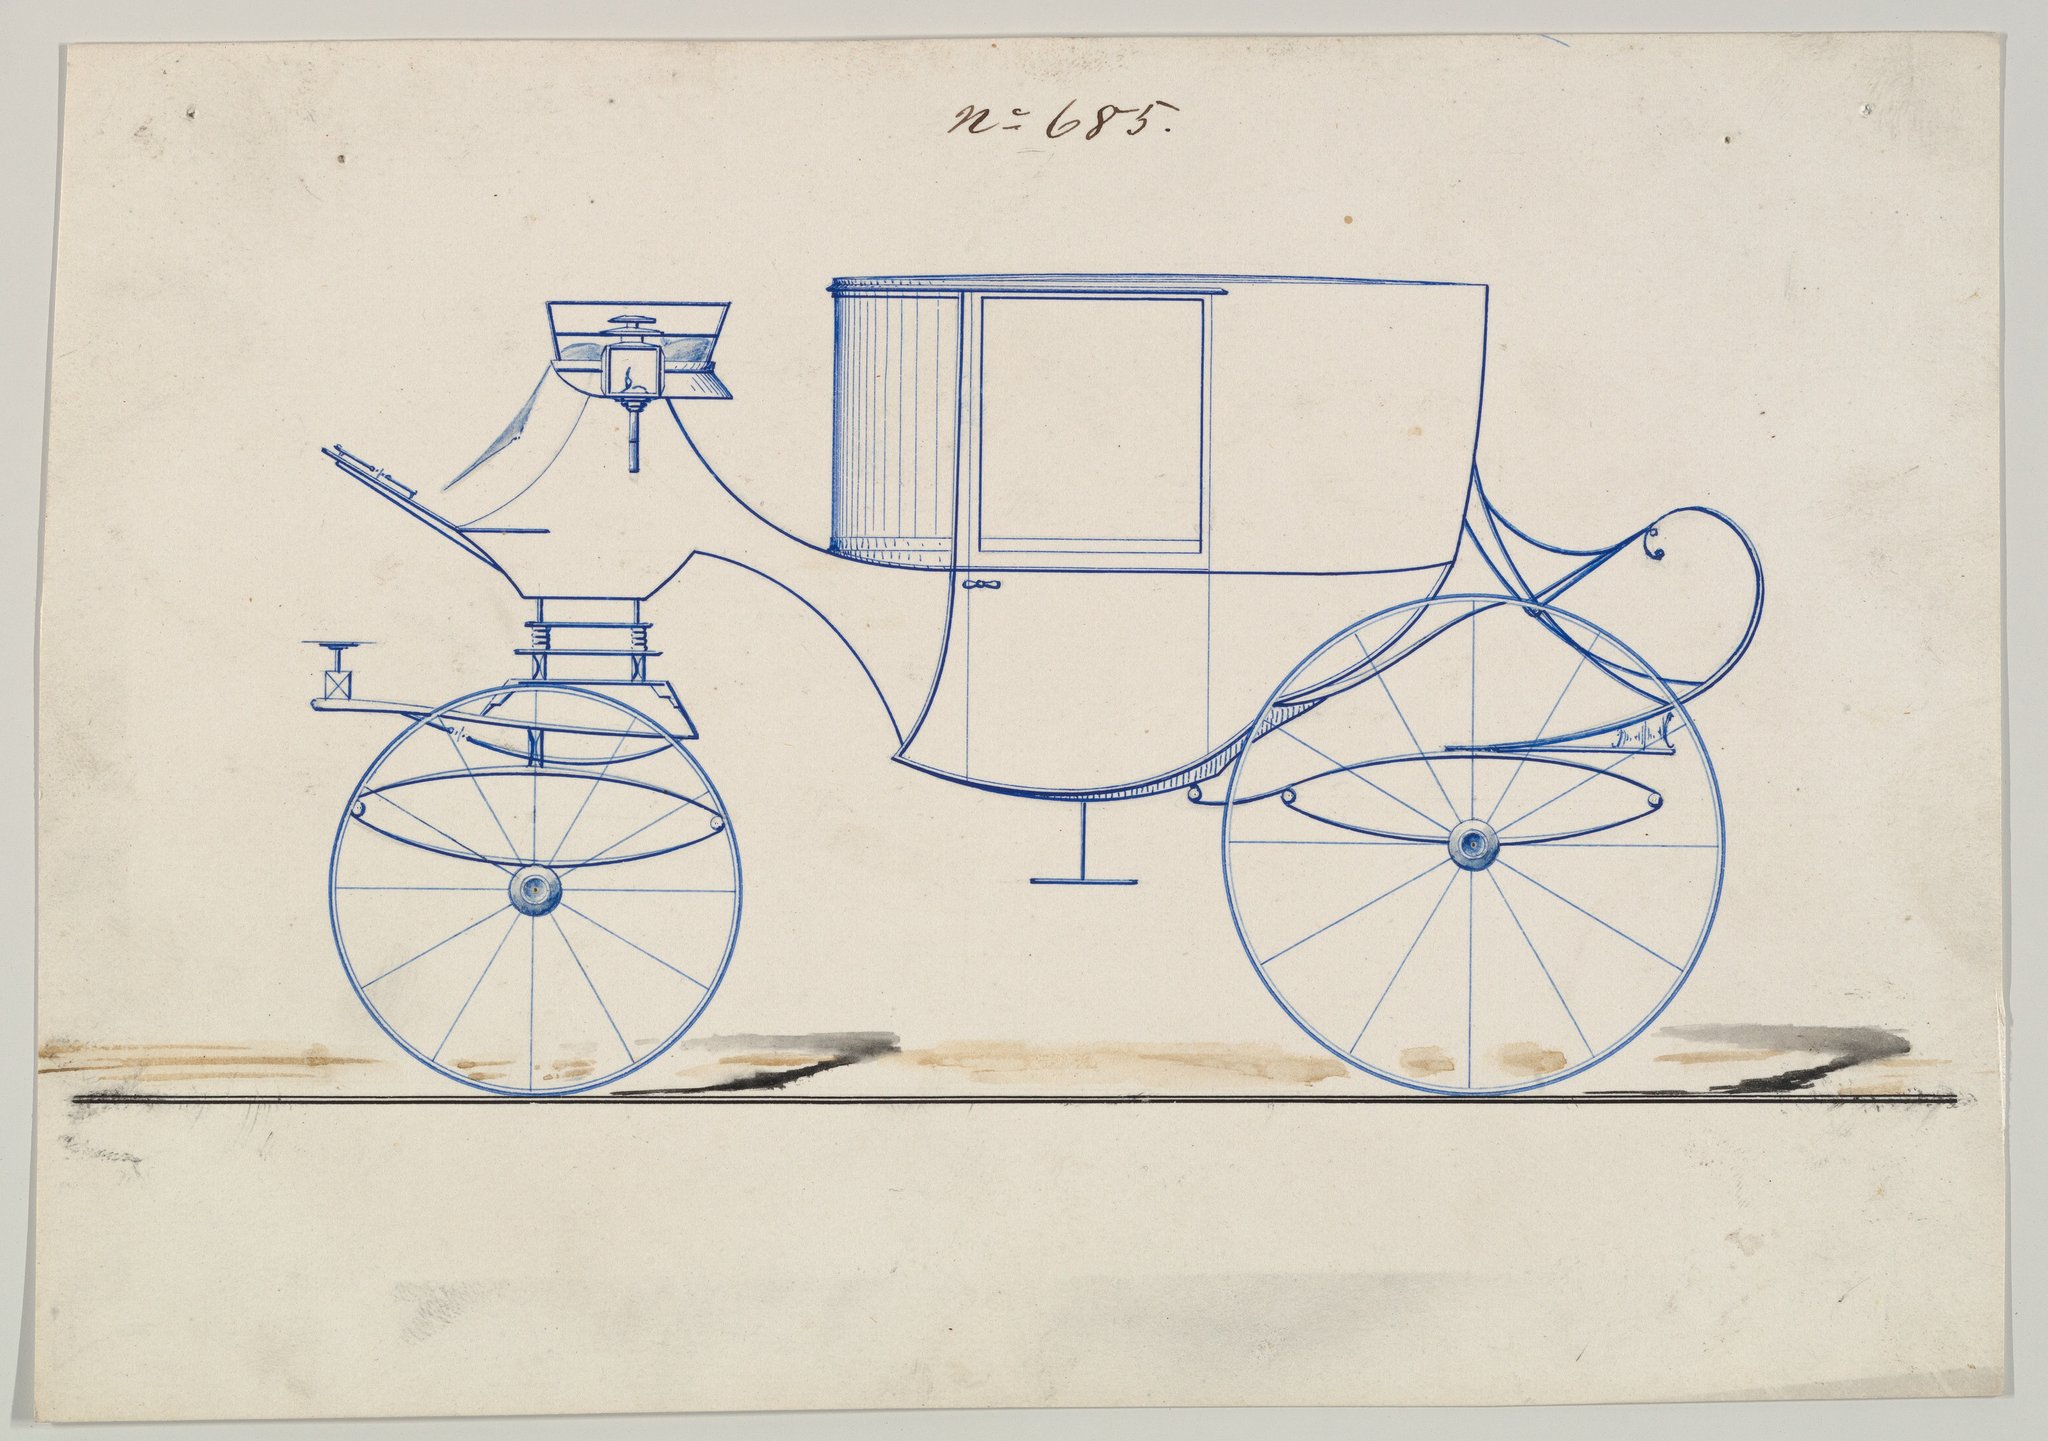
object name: drawing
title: Clarence # 685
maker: brewster & co.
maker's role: manufacturer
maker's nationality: american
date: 1850-1870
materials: watercolor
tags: carriages